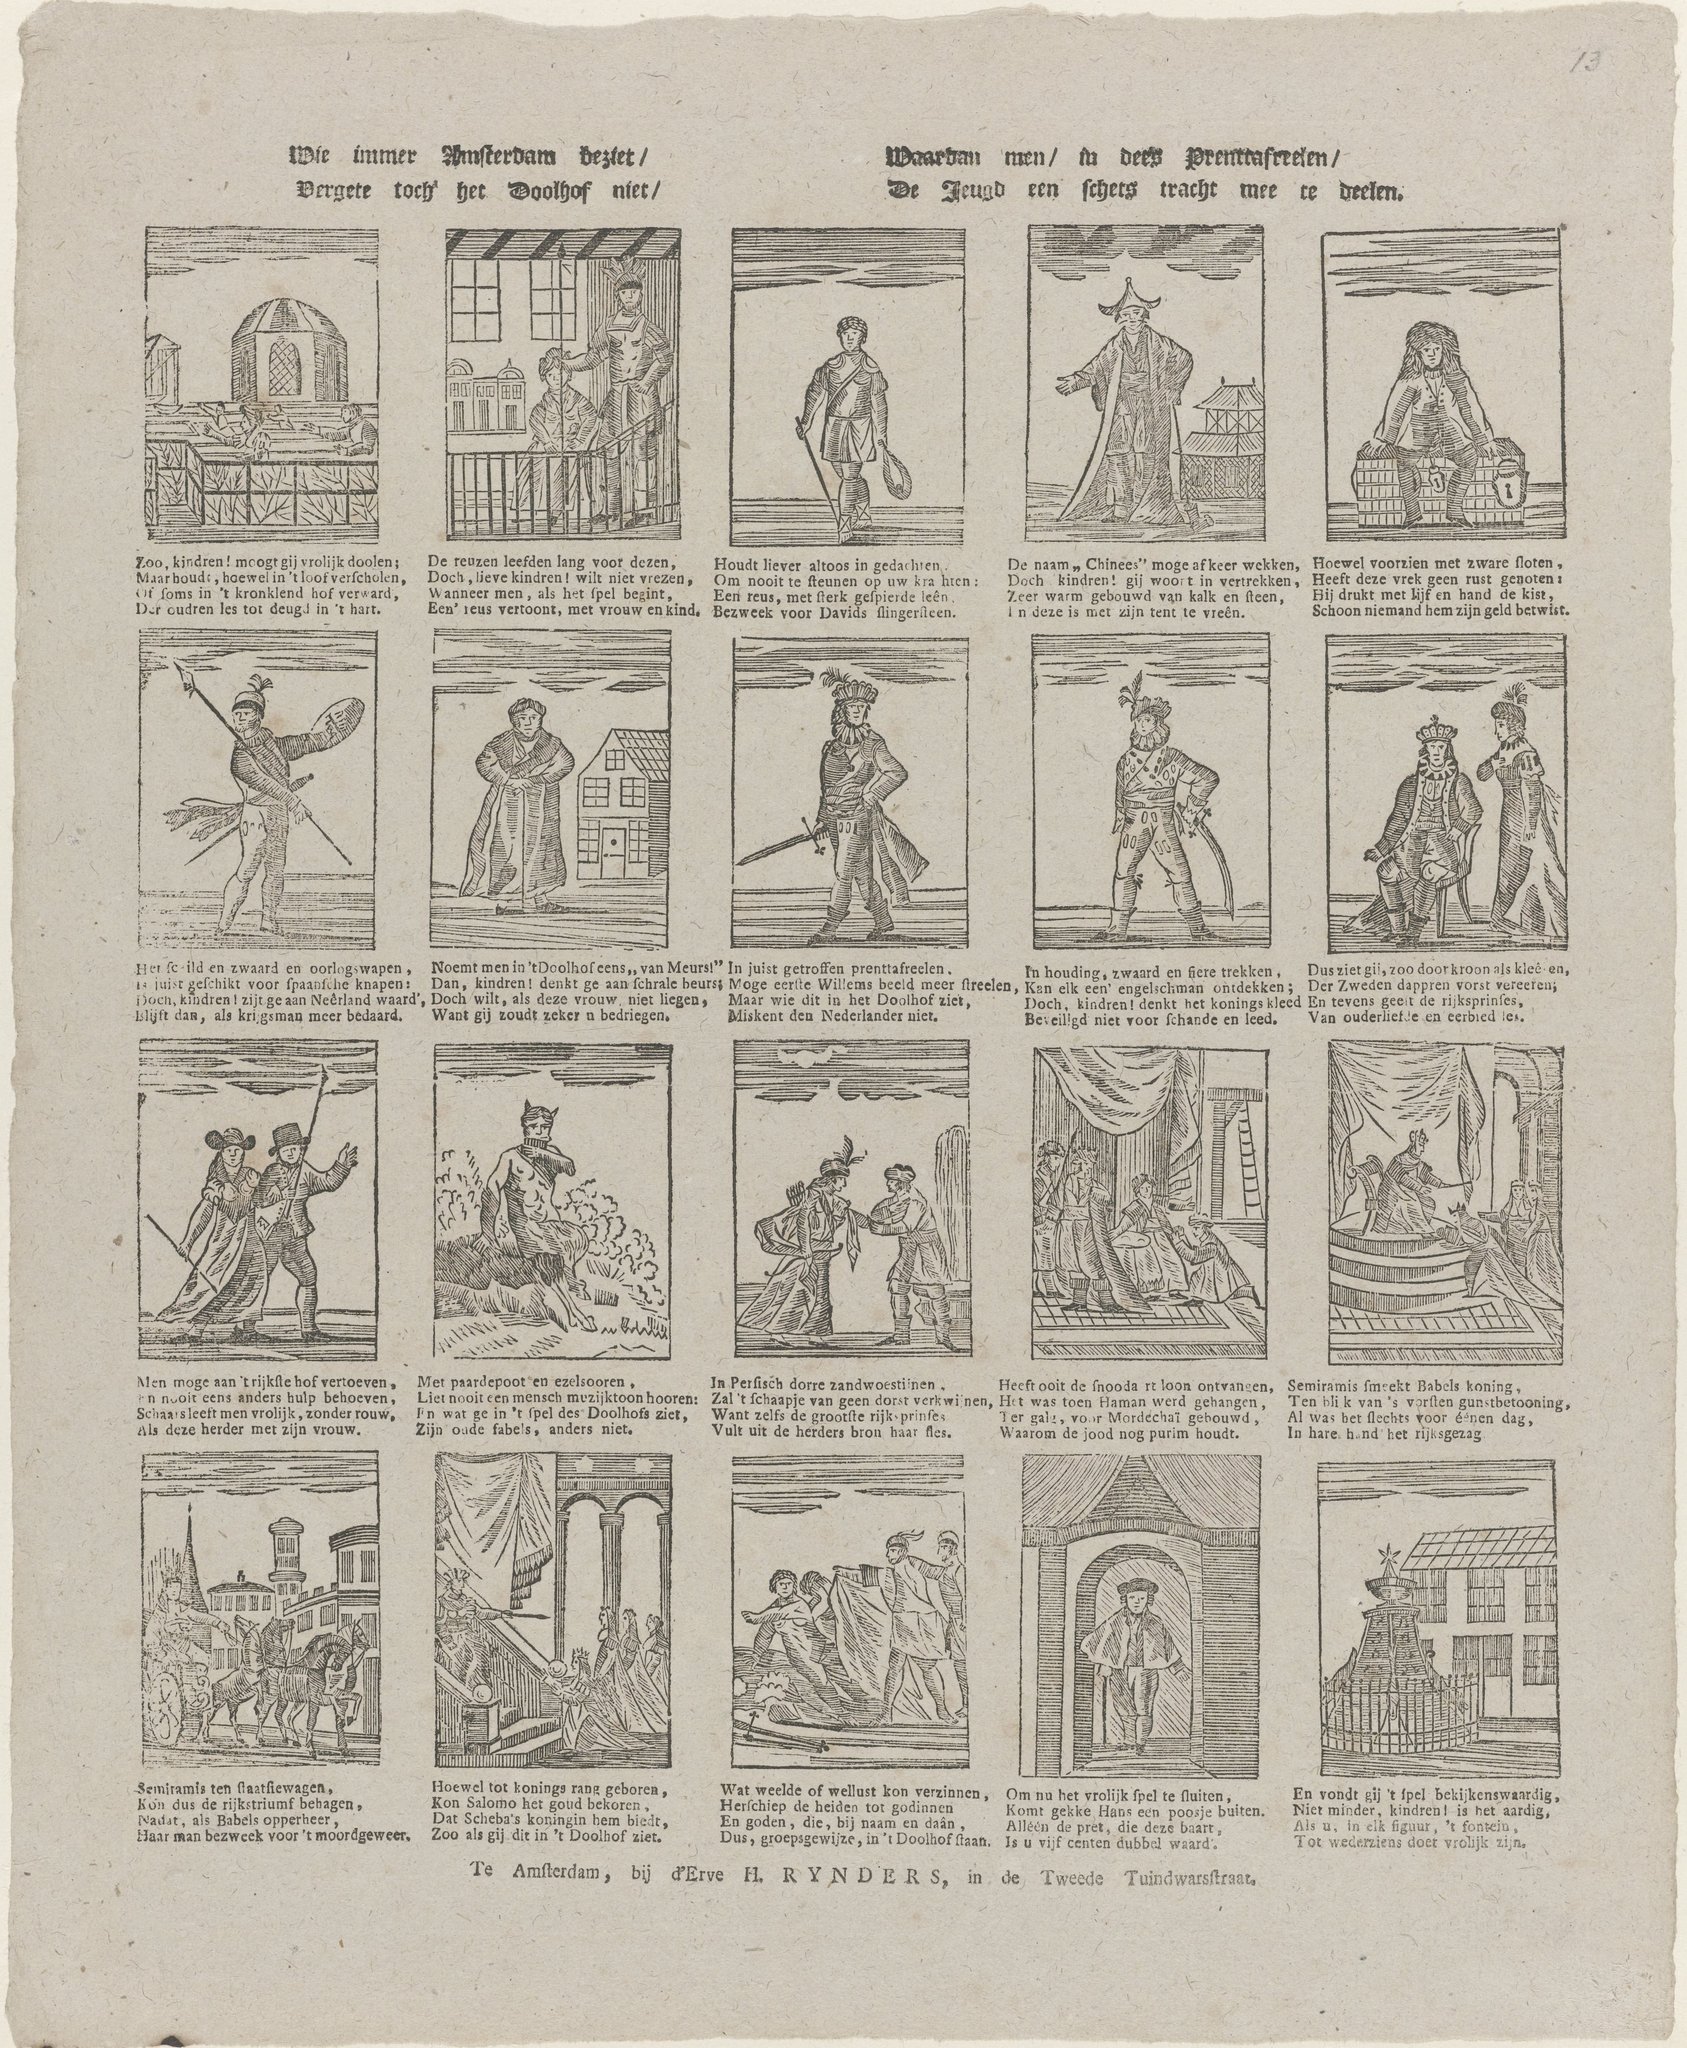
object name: popular print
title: Wie immer Amsterdam beziet / Vergete toch het doolhof niet / Waarvan men / in dees prenttafreelen / De jeugd een schets tracht mee te deelen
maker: Anonymous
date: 1831-1854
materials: paper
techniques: letterpress printing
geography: netherlands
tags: human types, labyrinth, maze ~ garden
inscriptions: collector's mark: Lugt 2760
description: Blad met 20 voorstellingen van de Amsterdamse 'Oude Doolhof' op de Prinsengracht, en verschillende figuren zoals een Chinees, een herder en een herderin. Onder elke afbeelding een vierregelig vers.